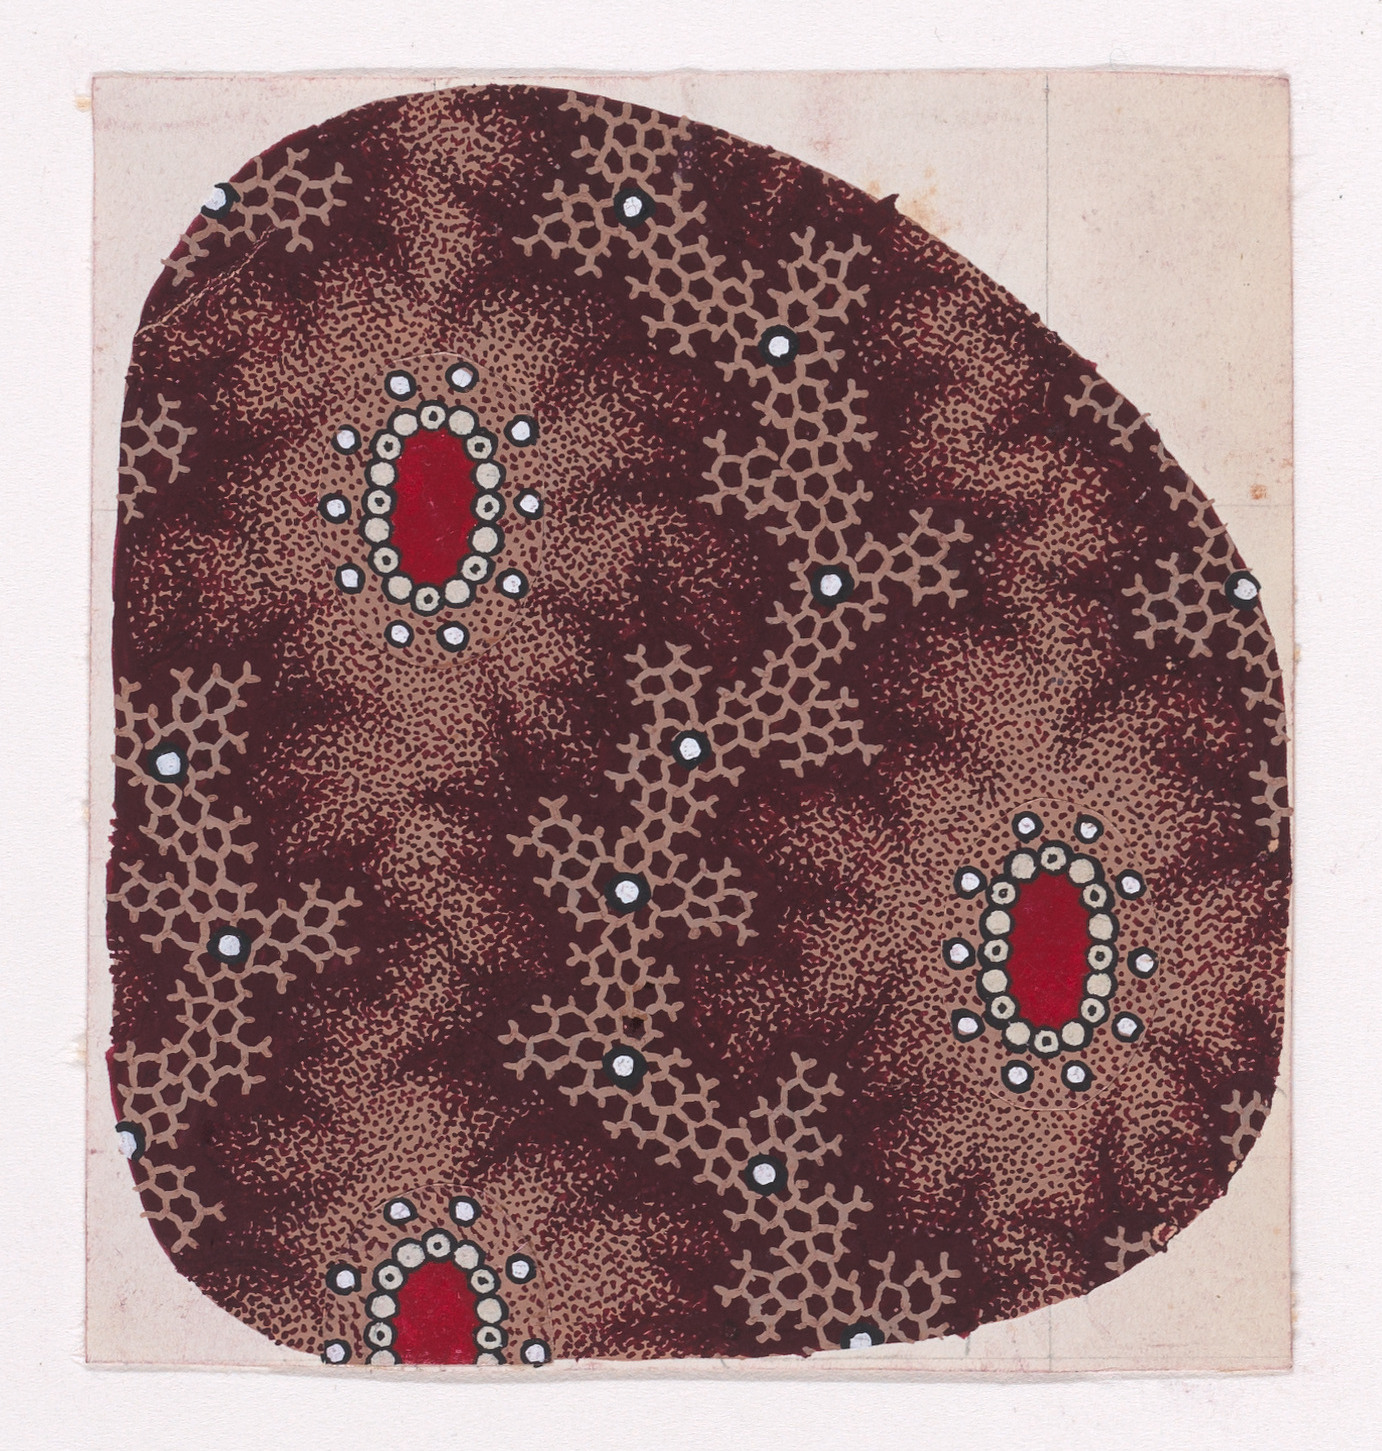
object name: drawing ornament architecture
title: Textile Design with Alternating Vertical Rows of Ovals Bordered with Pearls and Vertical Garlands of Honeycomb Structures Flanked with Offsetting Branches and Decorated with Pearls over a Stippled Background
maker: anonymous, alsatian, 19th century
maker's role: artist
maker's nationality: alsatian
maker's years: 1800-1900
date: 1840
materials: gouache